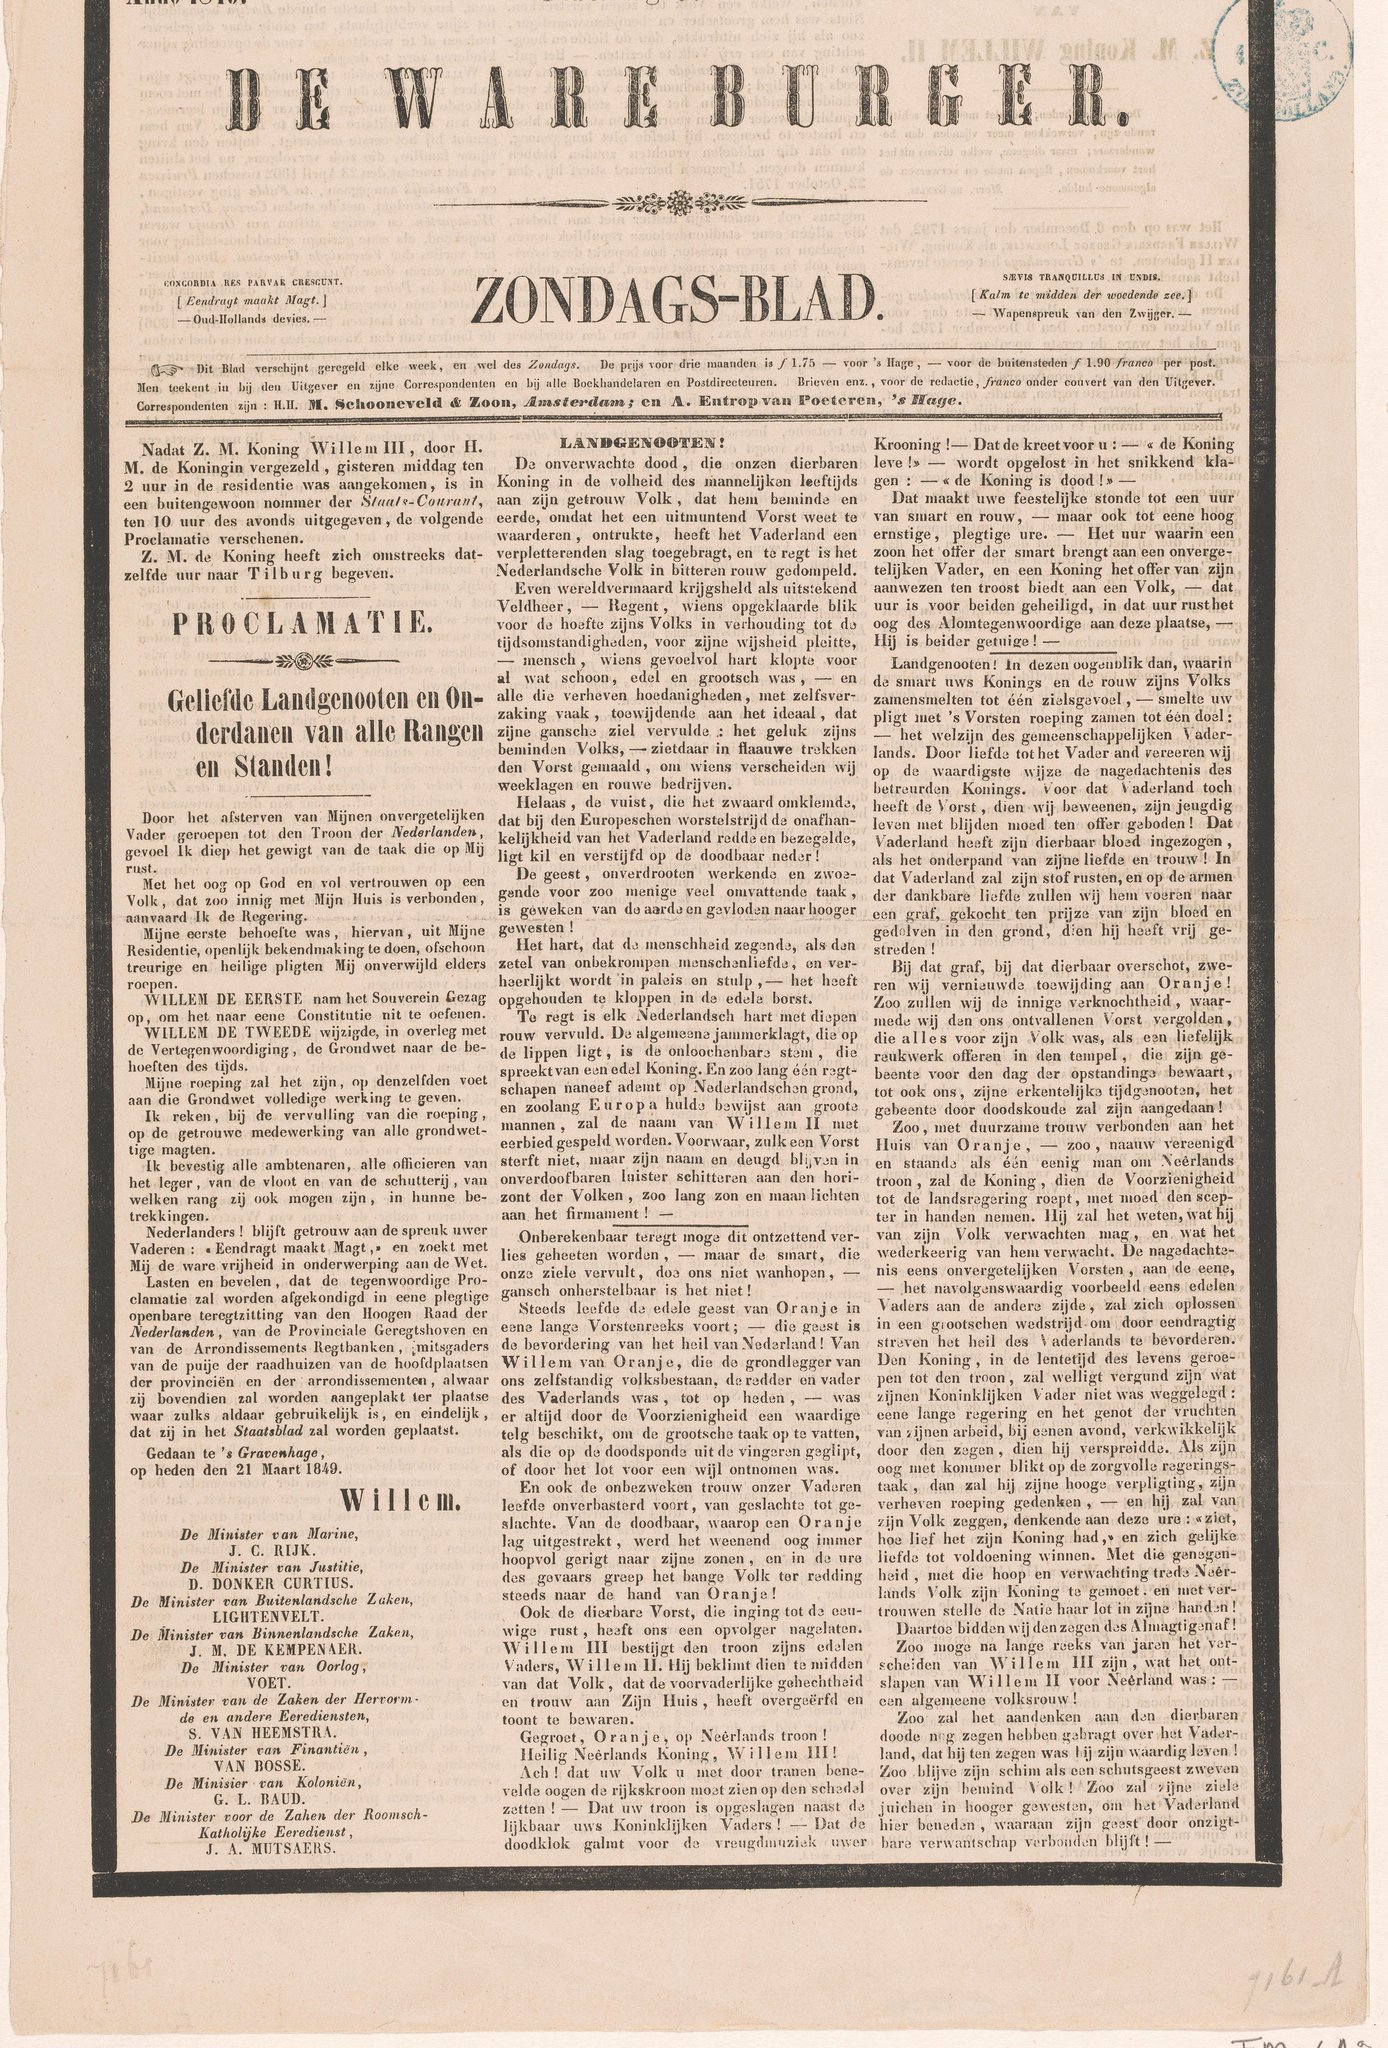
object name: proclamation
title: De Ware Burger. Zondags-Blad.Anno 1849. Donderdag 22 Maart. Nomm. 12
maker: v.h. sterck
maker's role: printer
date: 1849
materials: paper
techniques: letterpress printing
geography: voorburg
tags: willem iii (koning der nederlanden)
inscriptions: collector's mark: Lugt 2228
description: Exemplaar van de krant De Ware Burger van 22 maart met de publicatie van de eerste proclamatie uitgevaardigd door koning Willem III bij zijn terugkeer uit Engeland in Den Haag op 21 maart 1849. Blad met zwarte rouwranden bedrukt op beide zijden.